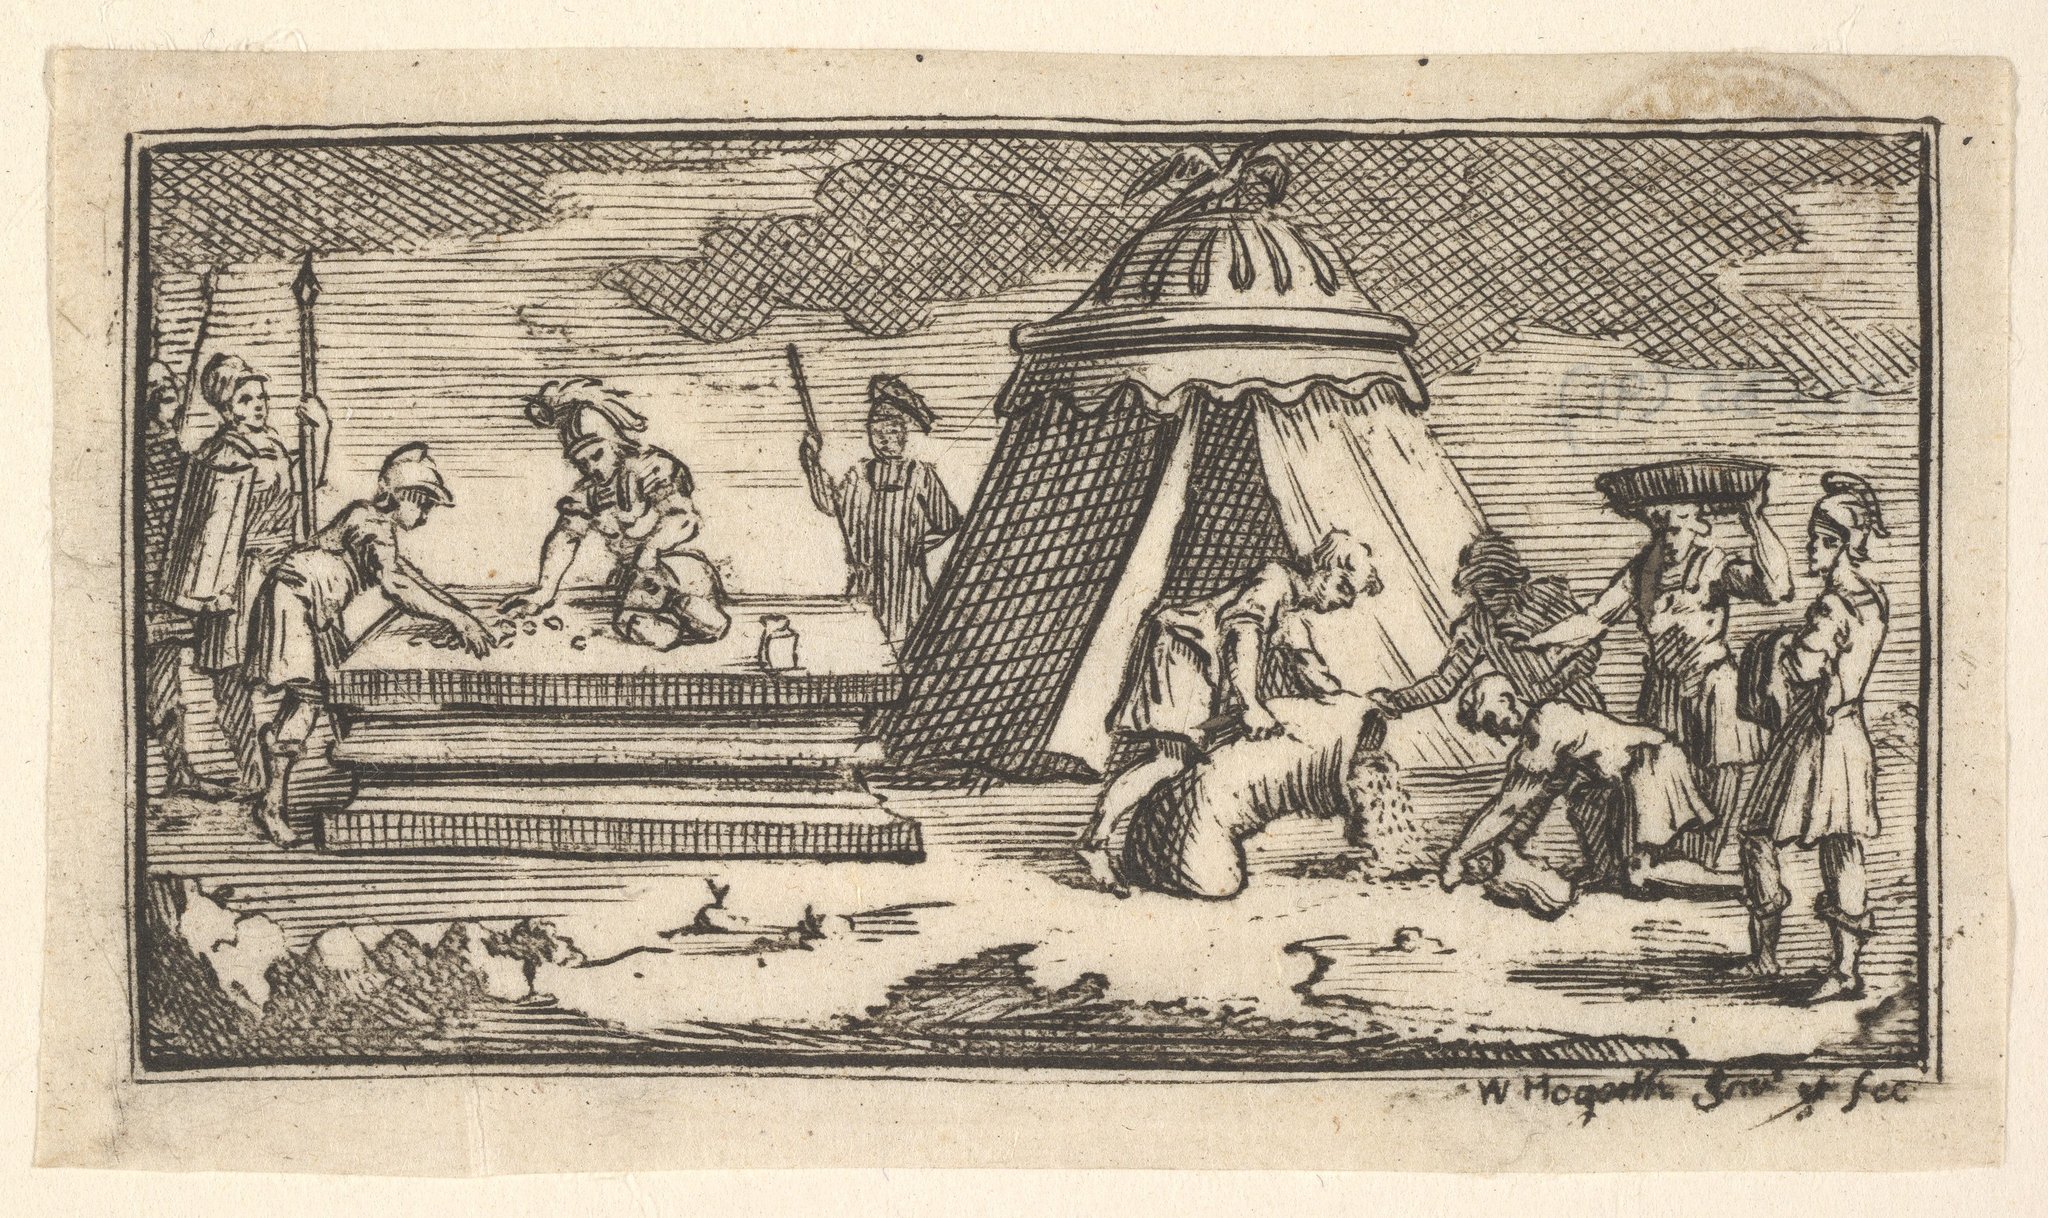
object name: print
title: Issued Barley Instead of Wheat [first version] (John Beaver, Roman Military Punishments, 1725)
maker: william hogarth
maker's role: artist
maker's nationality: british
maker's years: 1697-1764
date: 1725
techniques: etching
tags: tents,military,men,punishment